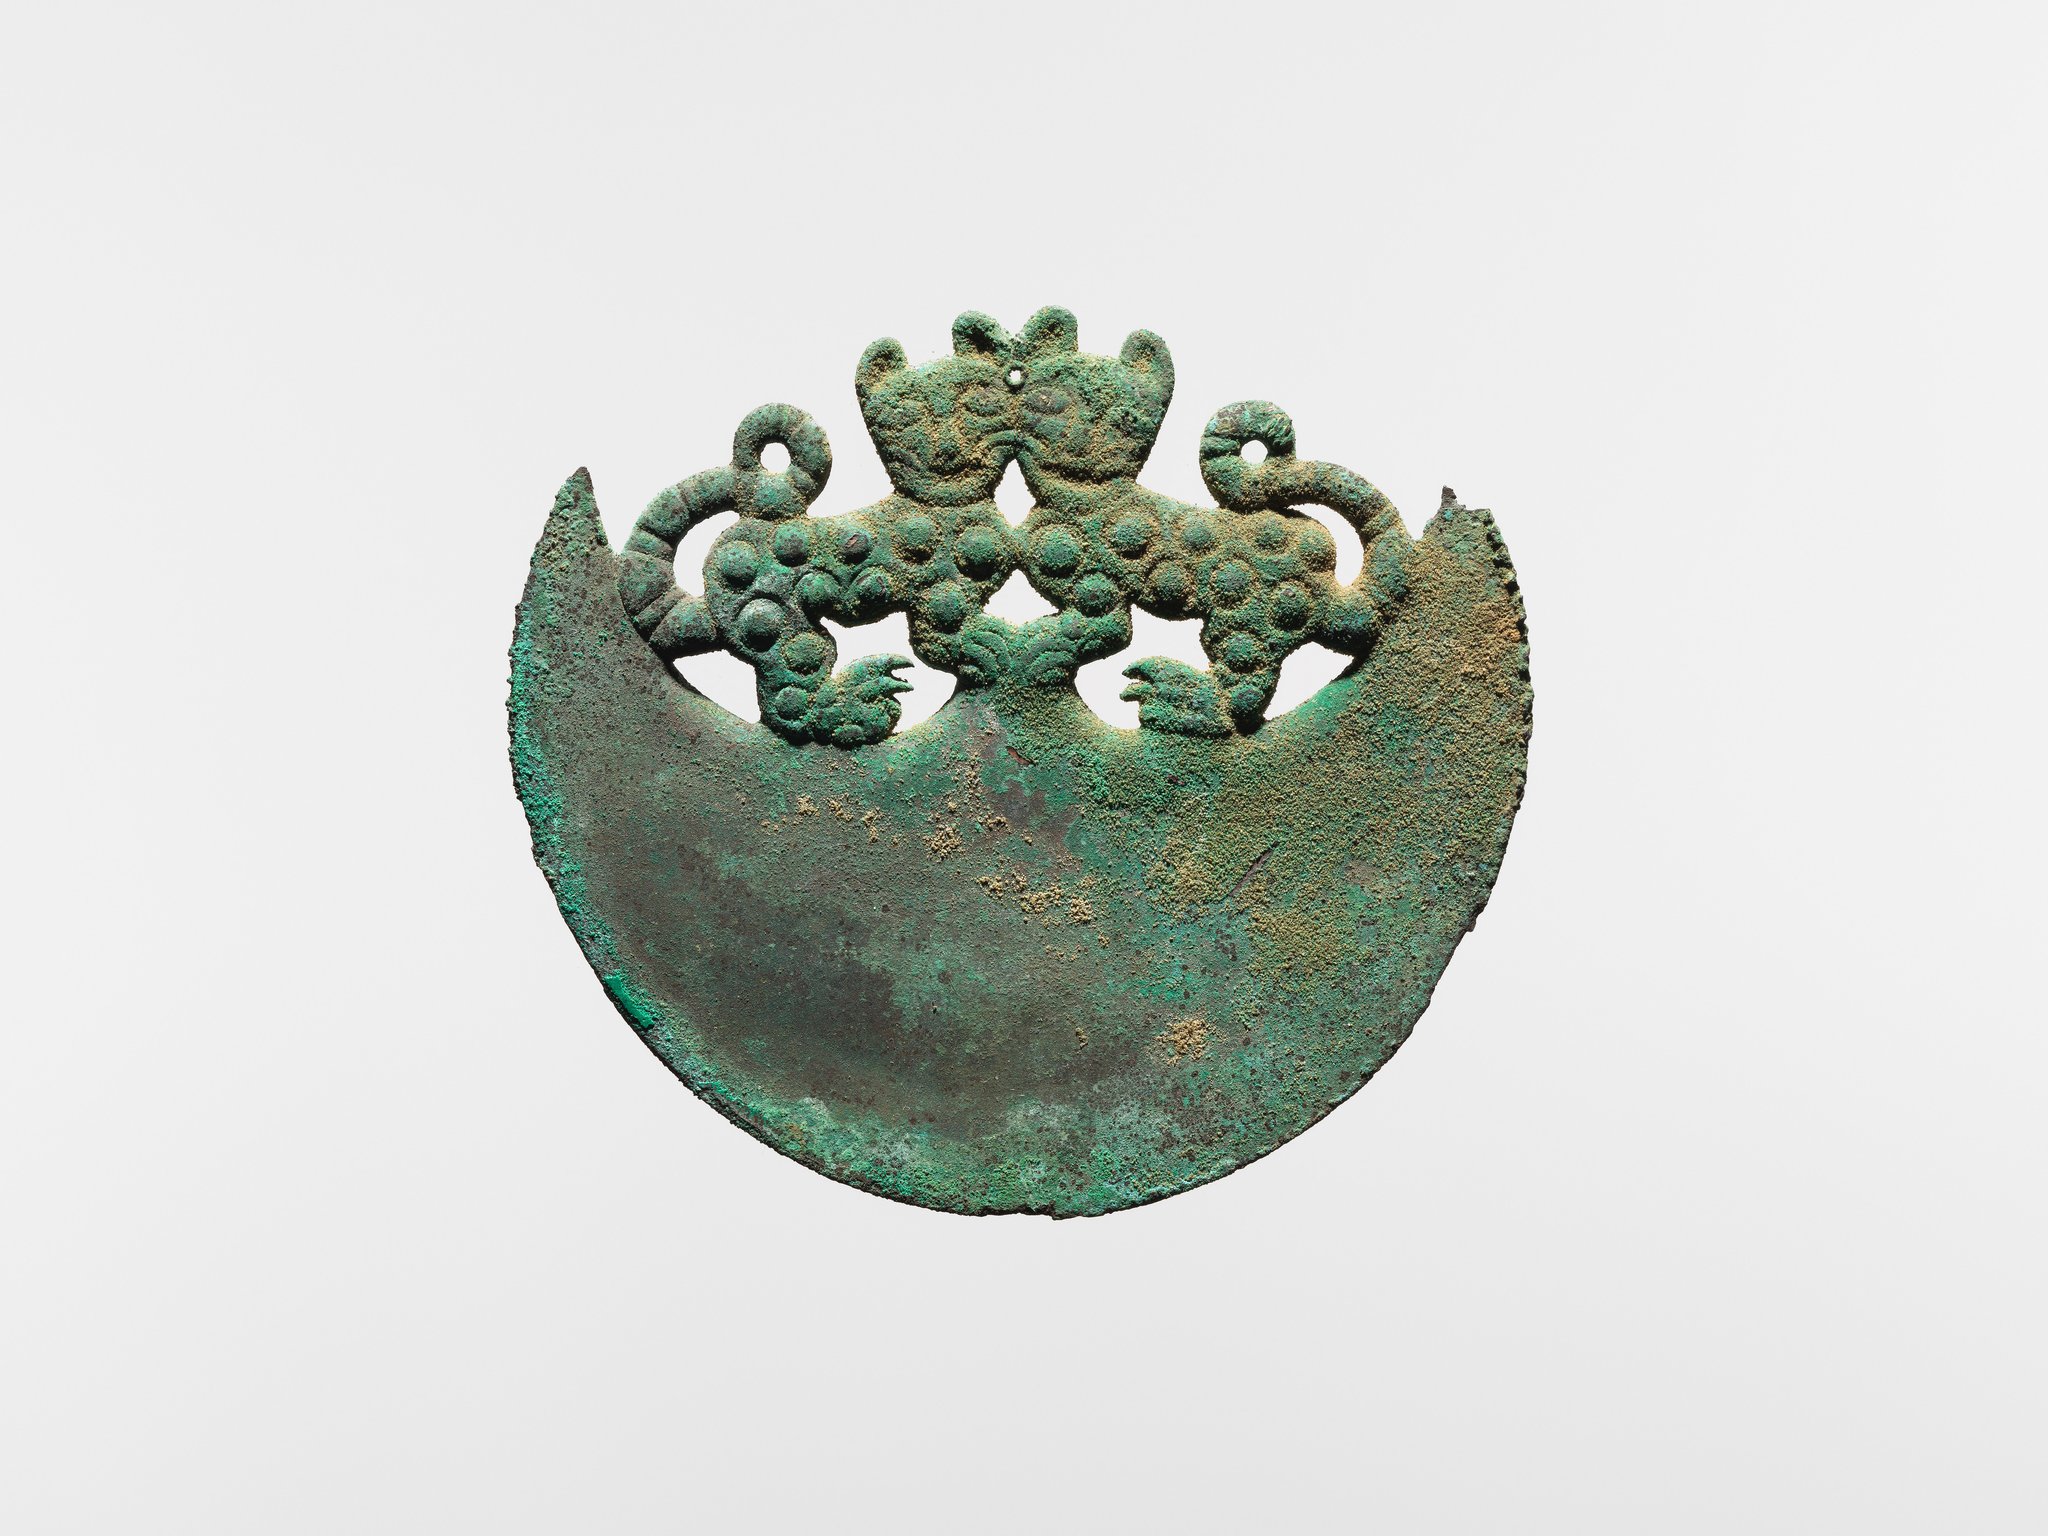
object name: ornament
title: Crescent, Two Felines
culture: moche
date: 501-700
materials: copper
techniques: hammering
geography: peru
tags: cats